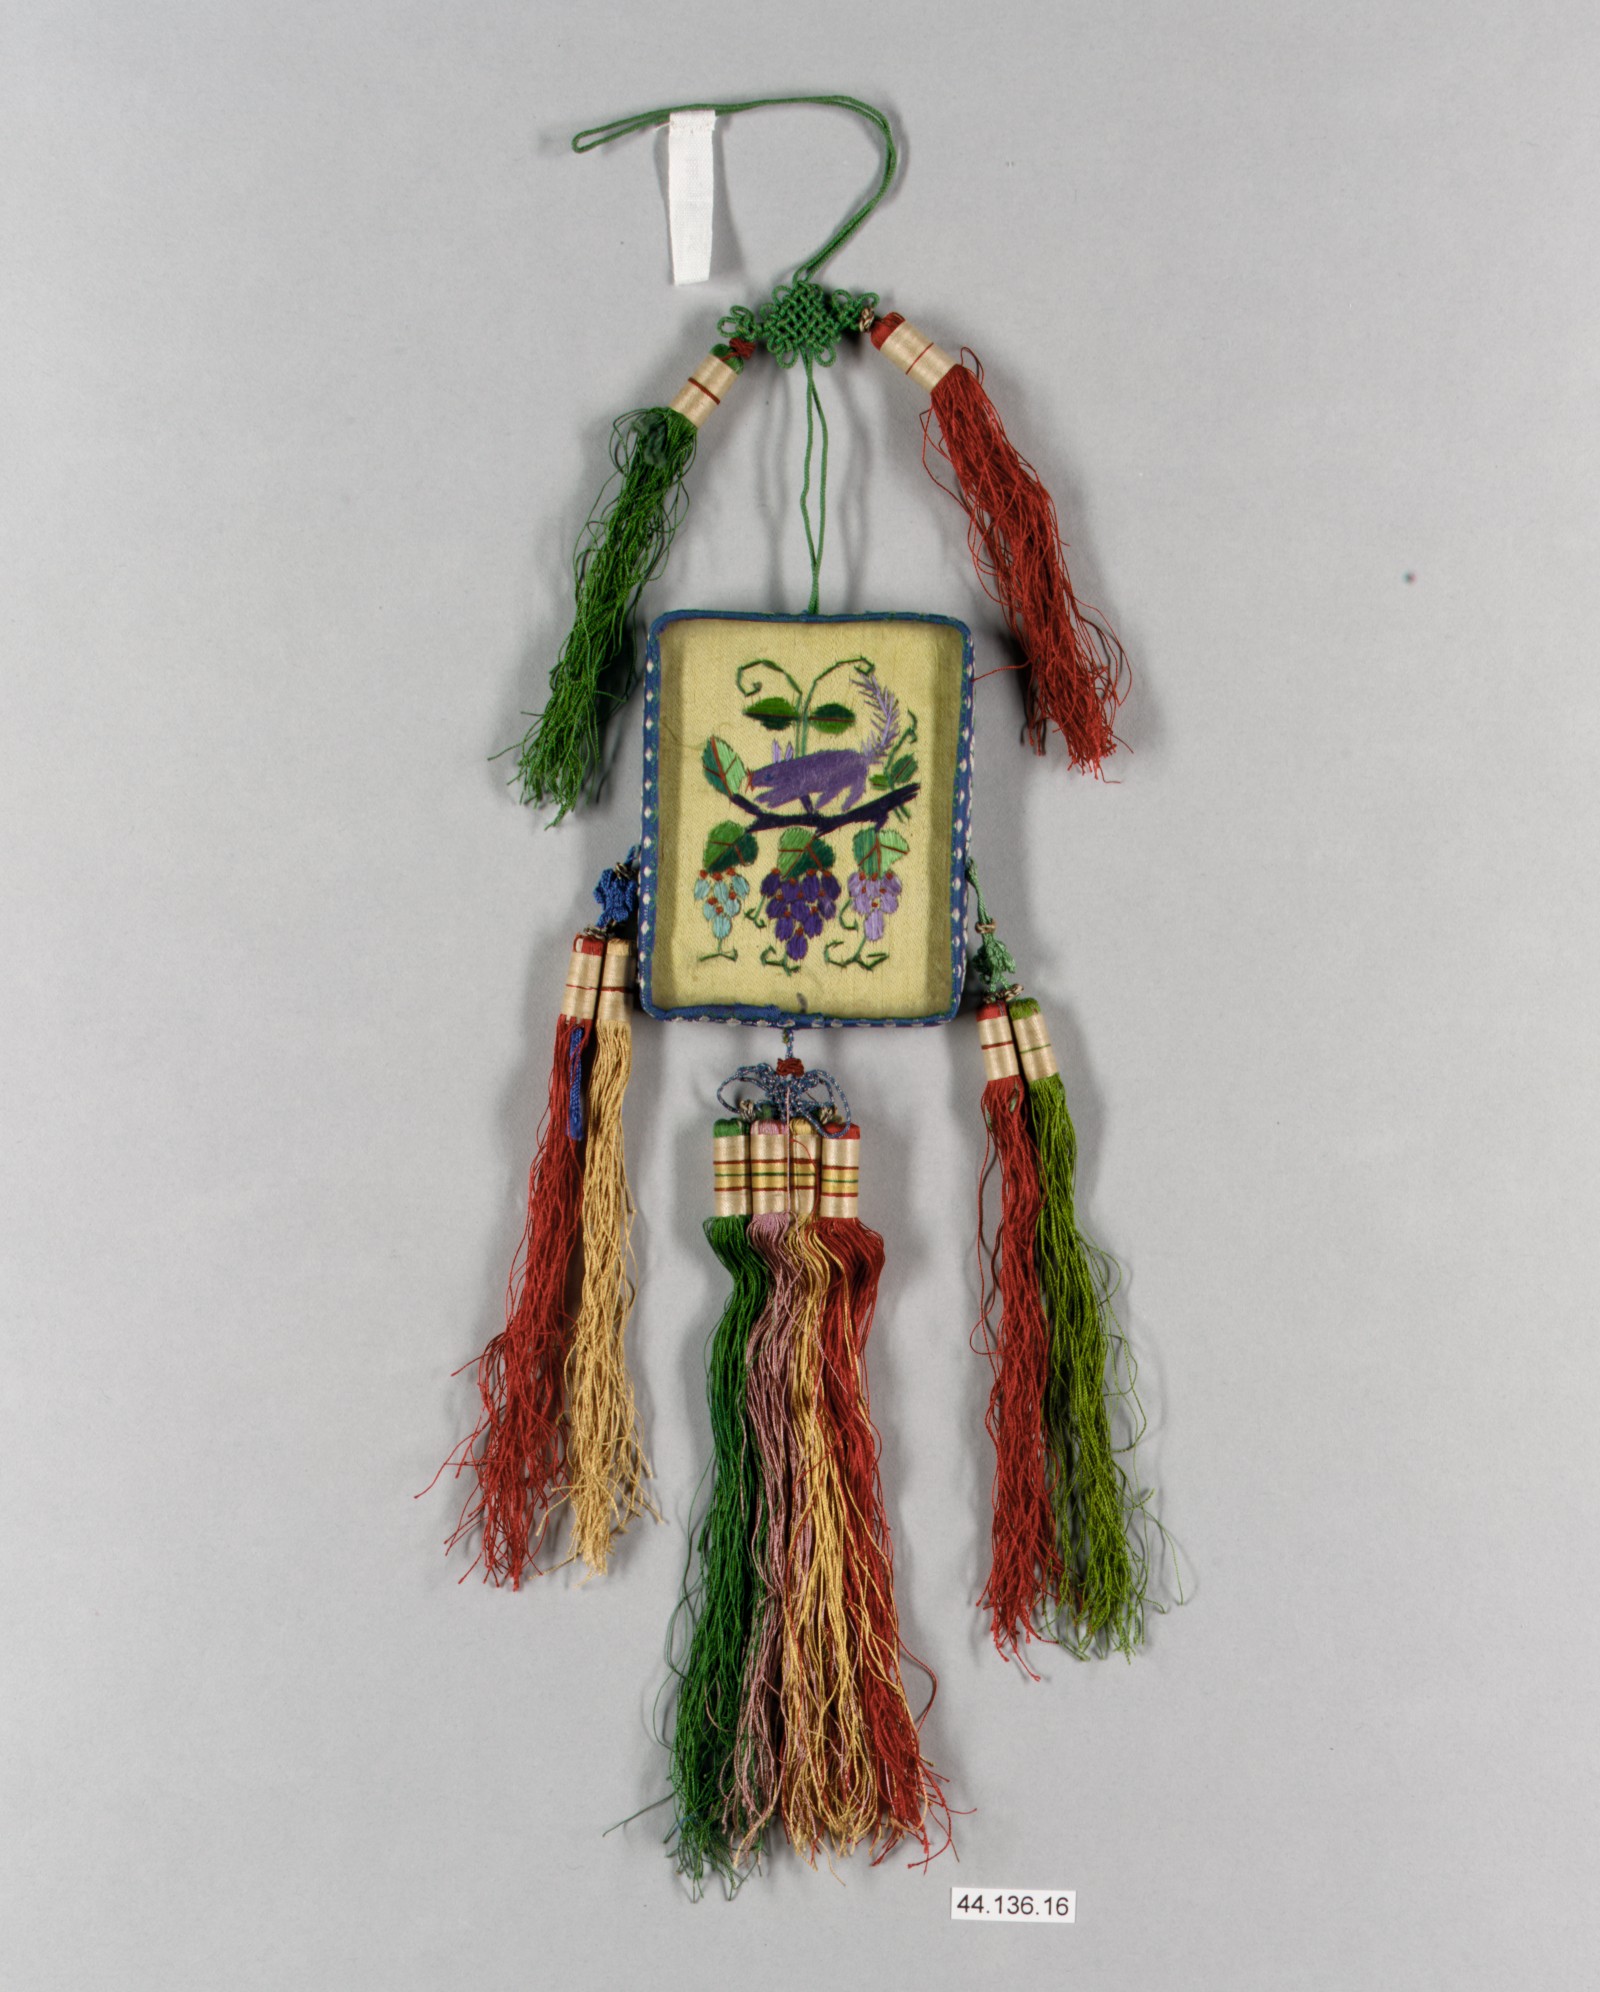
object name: mirror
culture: chinese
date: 1801-1900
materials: glass, silk